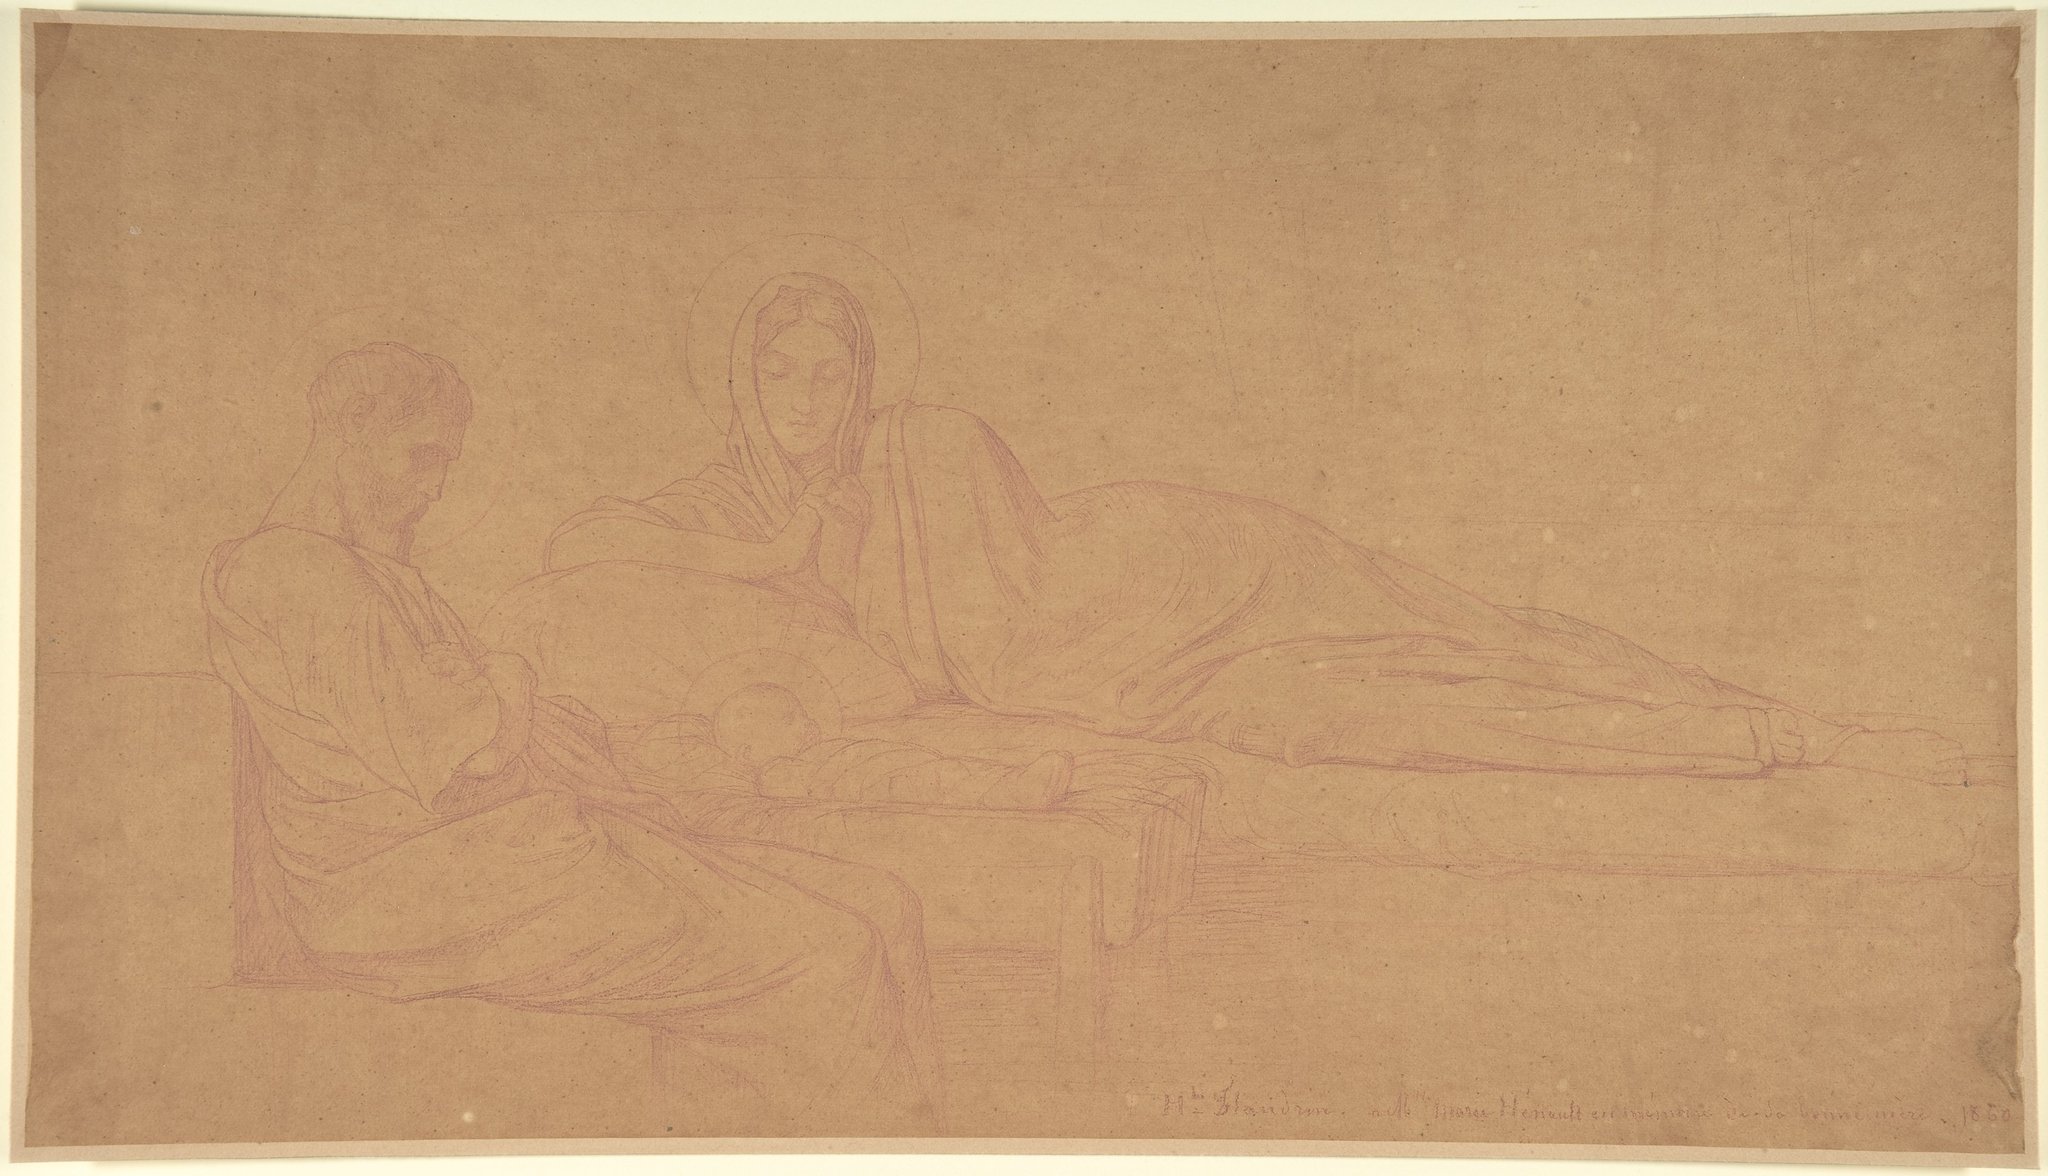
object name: drawing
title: The Nativity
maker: hippolyte flandrin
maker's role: draftsman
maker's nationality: french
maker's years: 1809-1864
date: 1860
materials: chalk, paper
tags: human figures,virgin mary,jesus